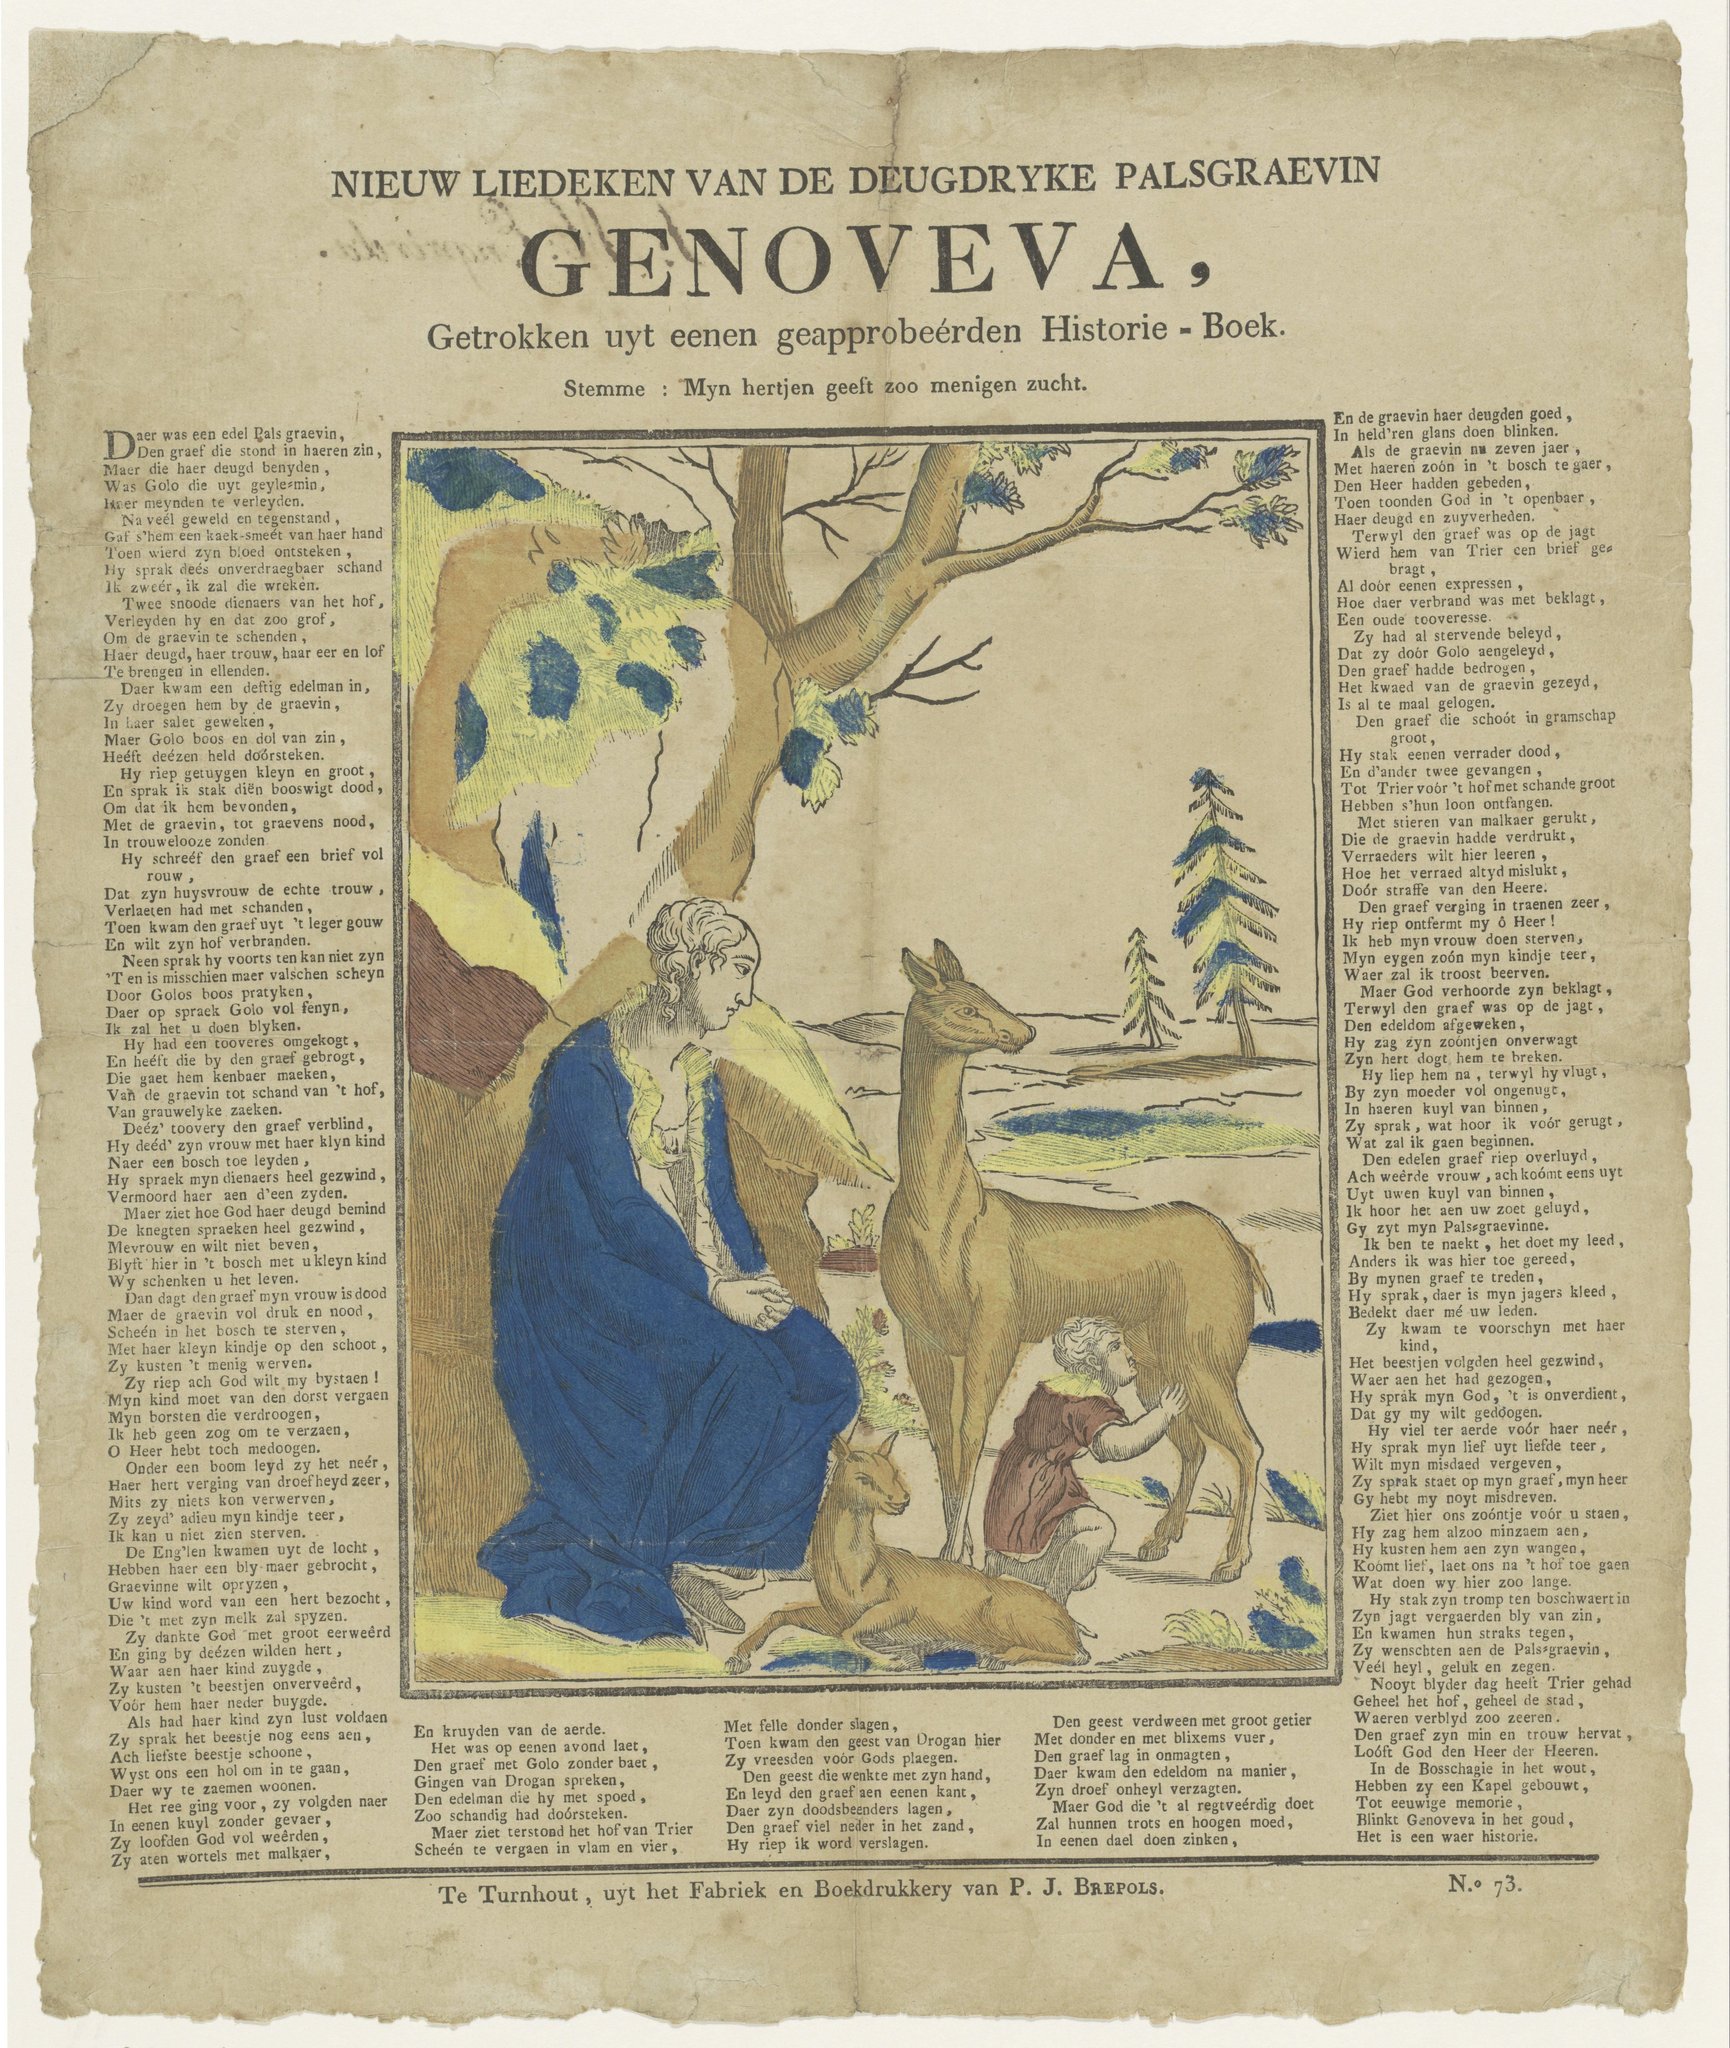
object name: print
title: Nieuw liedeken van de deugdryke palsgraevin / Genoveva, / Getrokken uyt eenen geapprobeérden historie - boek. / Stemme: Myn hertjen geeft zoo menigen zucht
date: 1800-1833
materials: paper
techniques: colour, letterpress printing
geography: turnhout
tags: genoveva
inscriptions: collector's mark: Lugt 2760, collector's mark: Lugt 2228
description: Genoveva van Brabant zittend in de wildernis met haar zoontje. Haar zoontje wordt gezoogd door een ree. Op de voorgrond ligt een jong reetje. Rondom tekst in boekdruk in het Nederlands en in het Frans. Genummerd rechtsonder: No. 73.